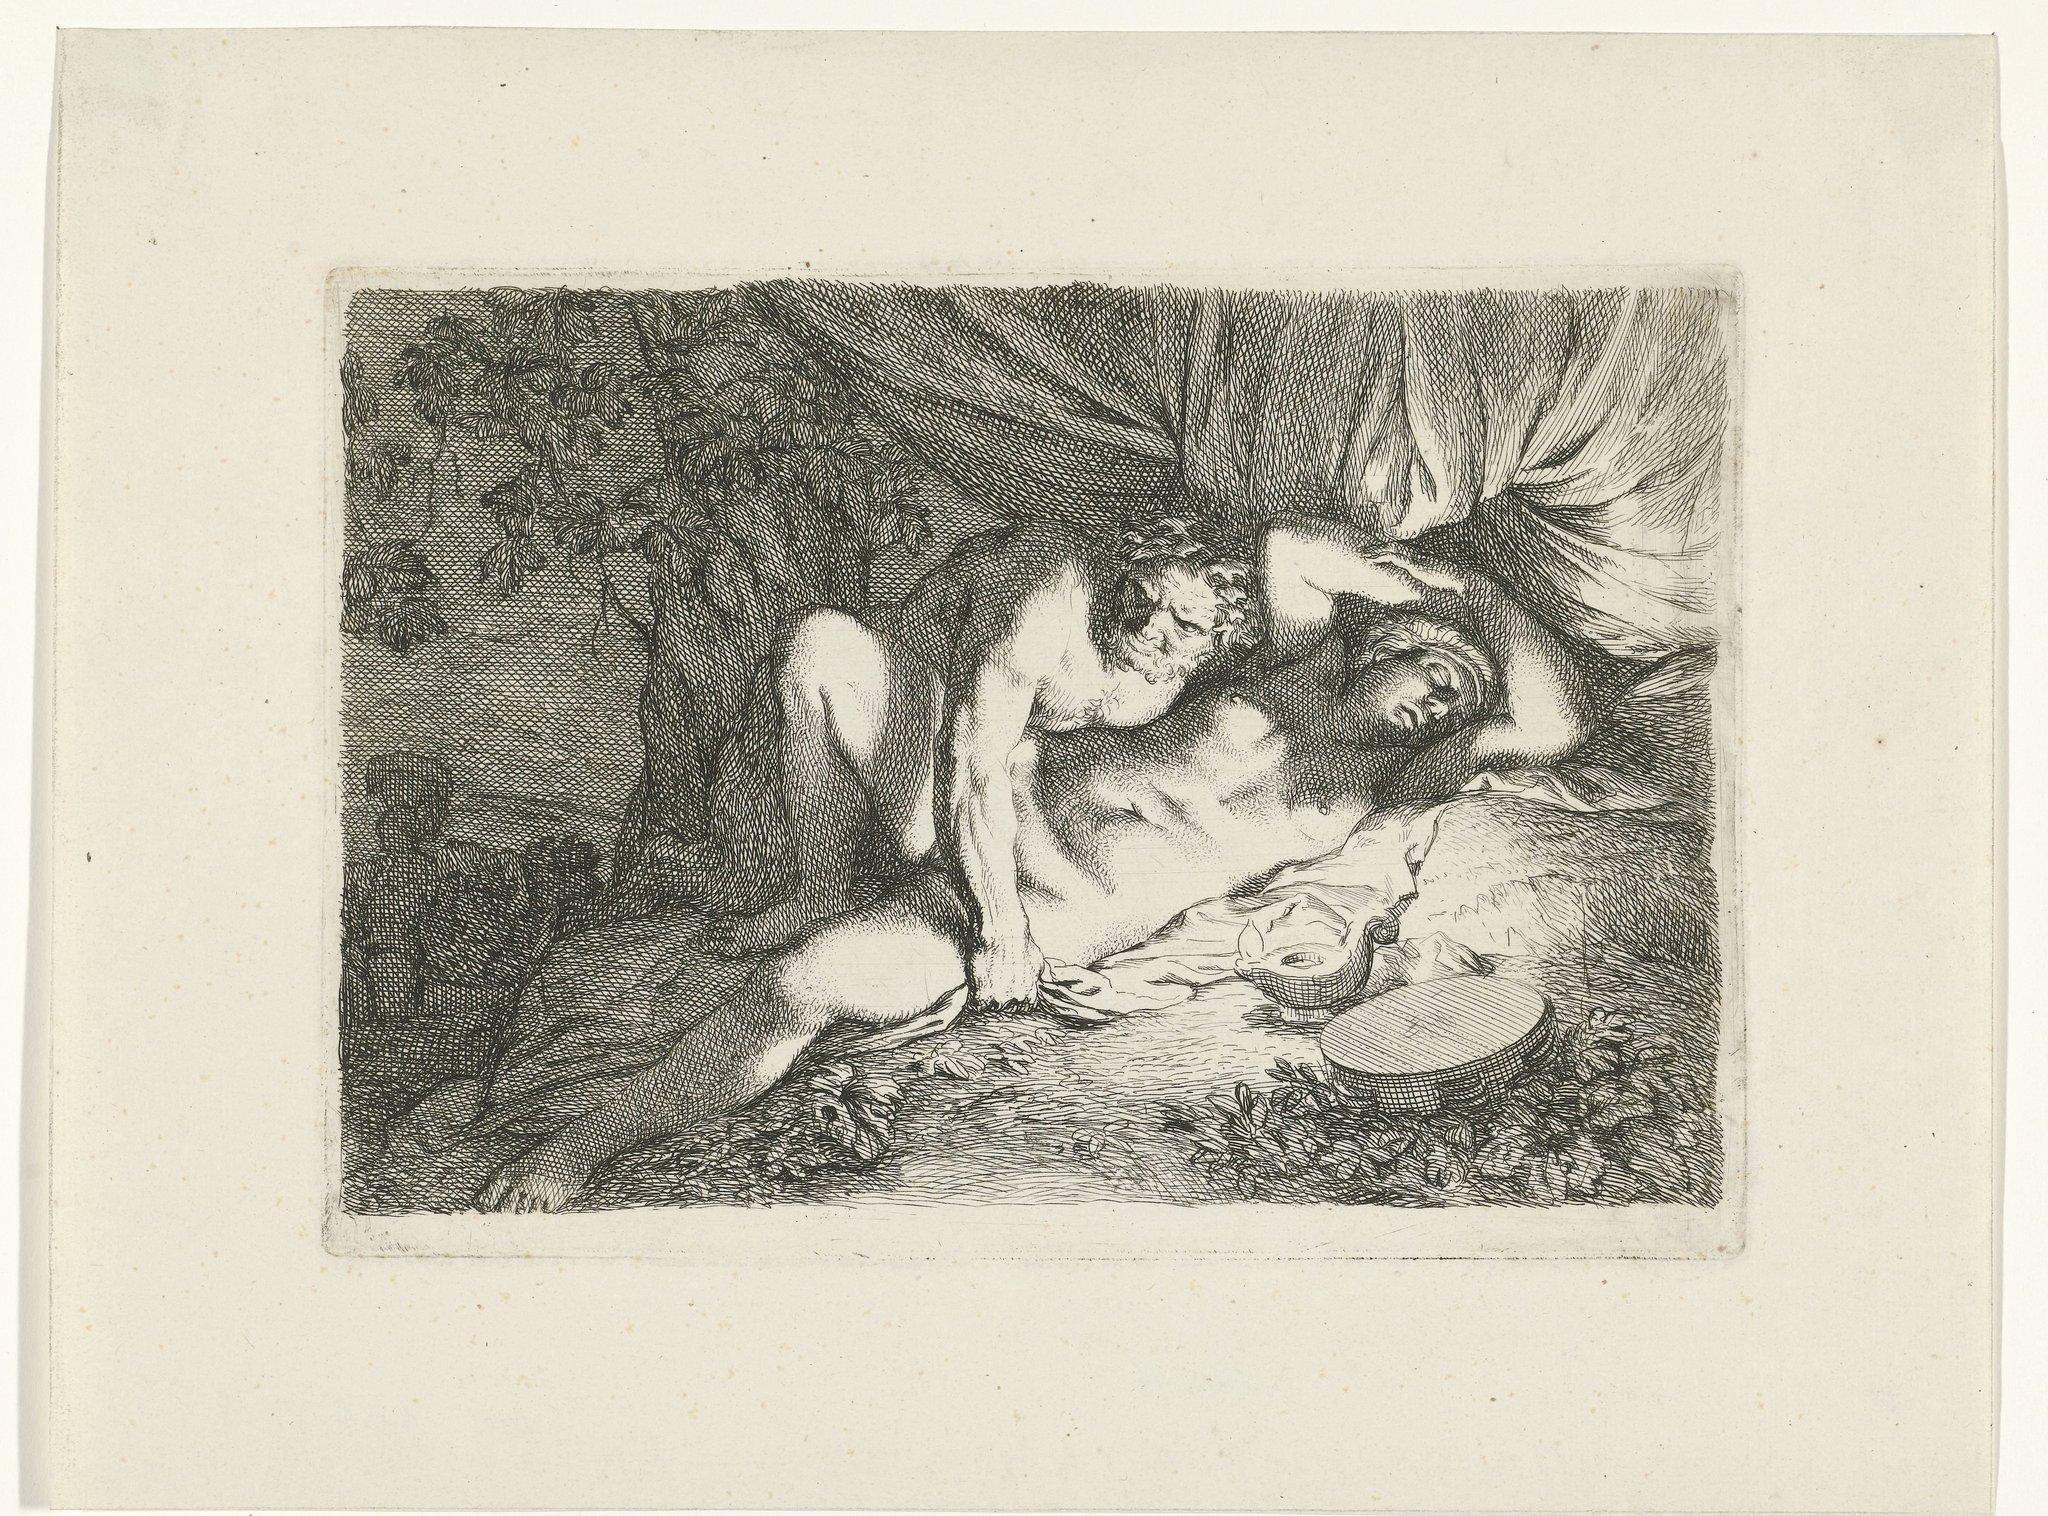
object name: print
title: Jupiter en Antiope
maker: gerard de lairesse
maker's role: draughtsman, painter, print maker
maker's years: 1641-1711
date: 1675-1680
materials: paper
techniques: etching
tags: jupiter, disguised as a satyr, approaches the sleeping antiope; the eagle may be standing nearby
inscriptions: collector's mark: Lugt 240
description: Jupiter verrast de nimf Antiope in haar slaap in de gedaante van een sater. Het gewaad van Antiope heeft Jupiter opzij getrokken om haar te kunnen verkrachten. Scène afkomstig uit de Metamorfosen van Ovidius.